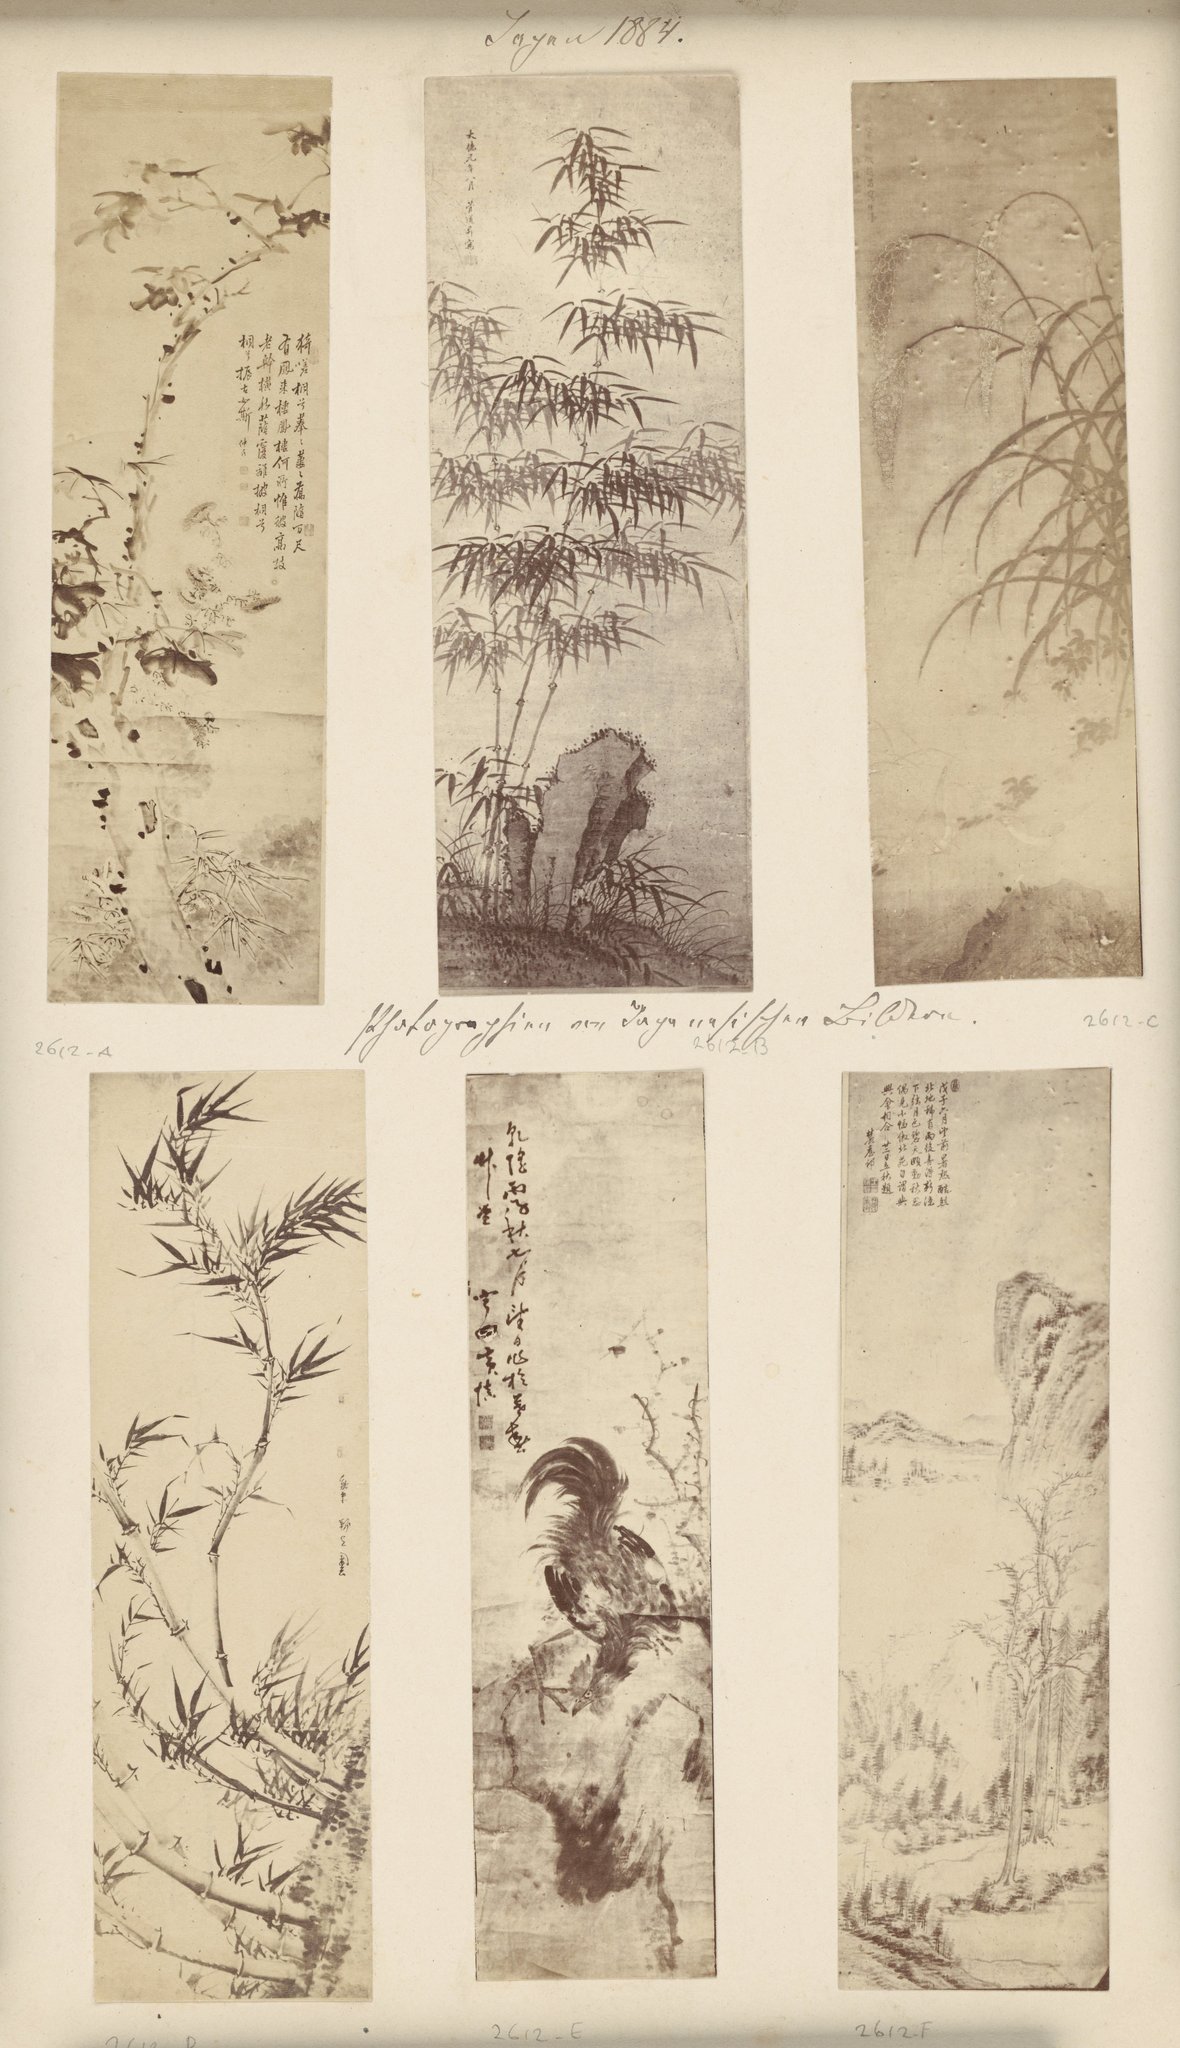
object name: photograph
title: Fotoreproductie van een schildering van een haan en takken, linksboven enkele Japanse tekens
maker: Anonymous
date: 1884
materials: cardboard, paper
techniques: albumen print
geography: japan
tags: fowl (cock, hen, chicken, etc.), japan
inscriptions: inscription: ‘[onleesbaar]’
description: Onderdeel van een blad met zes fotoreproducties van geschilderde bomen.